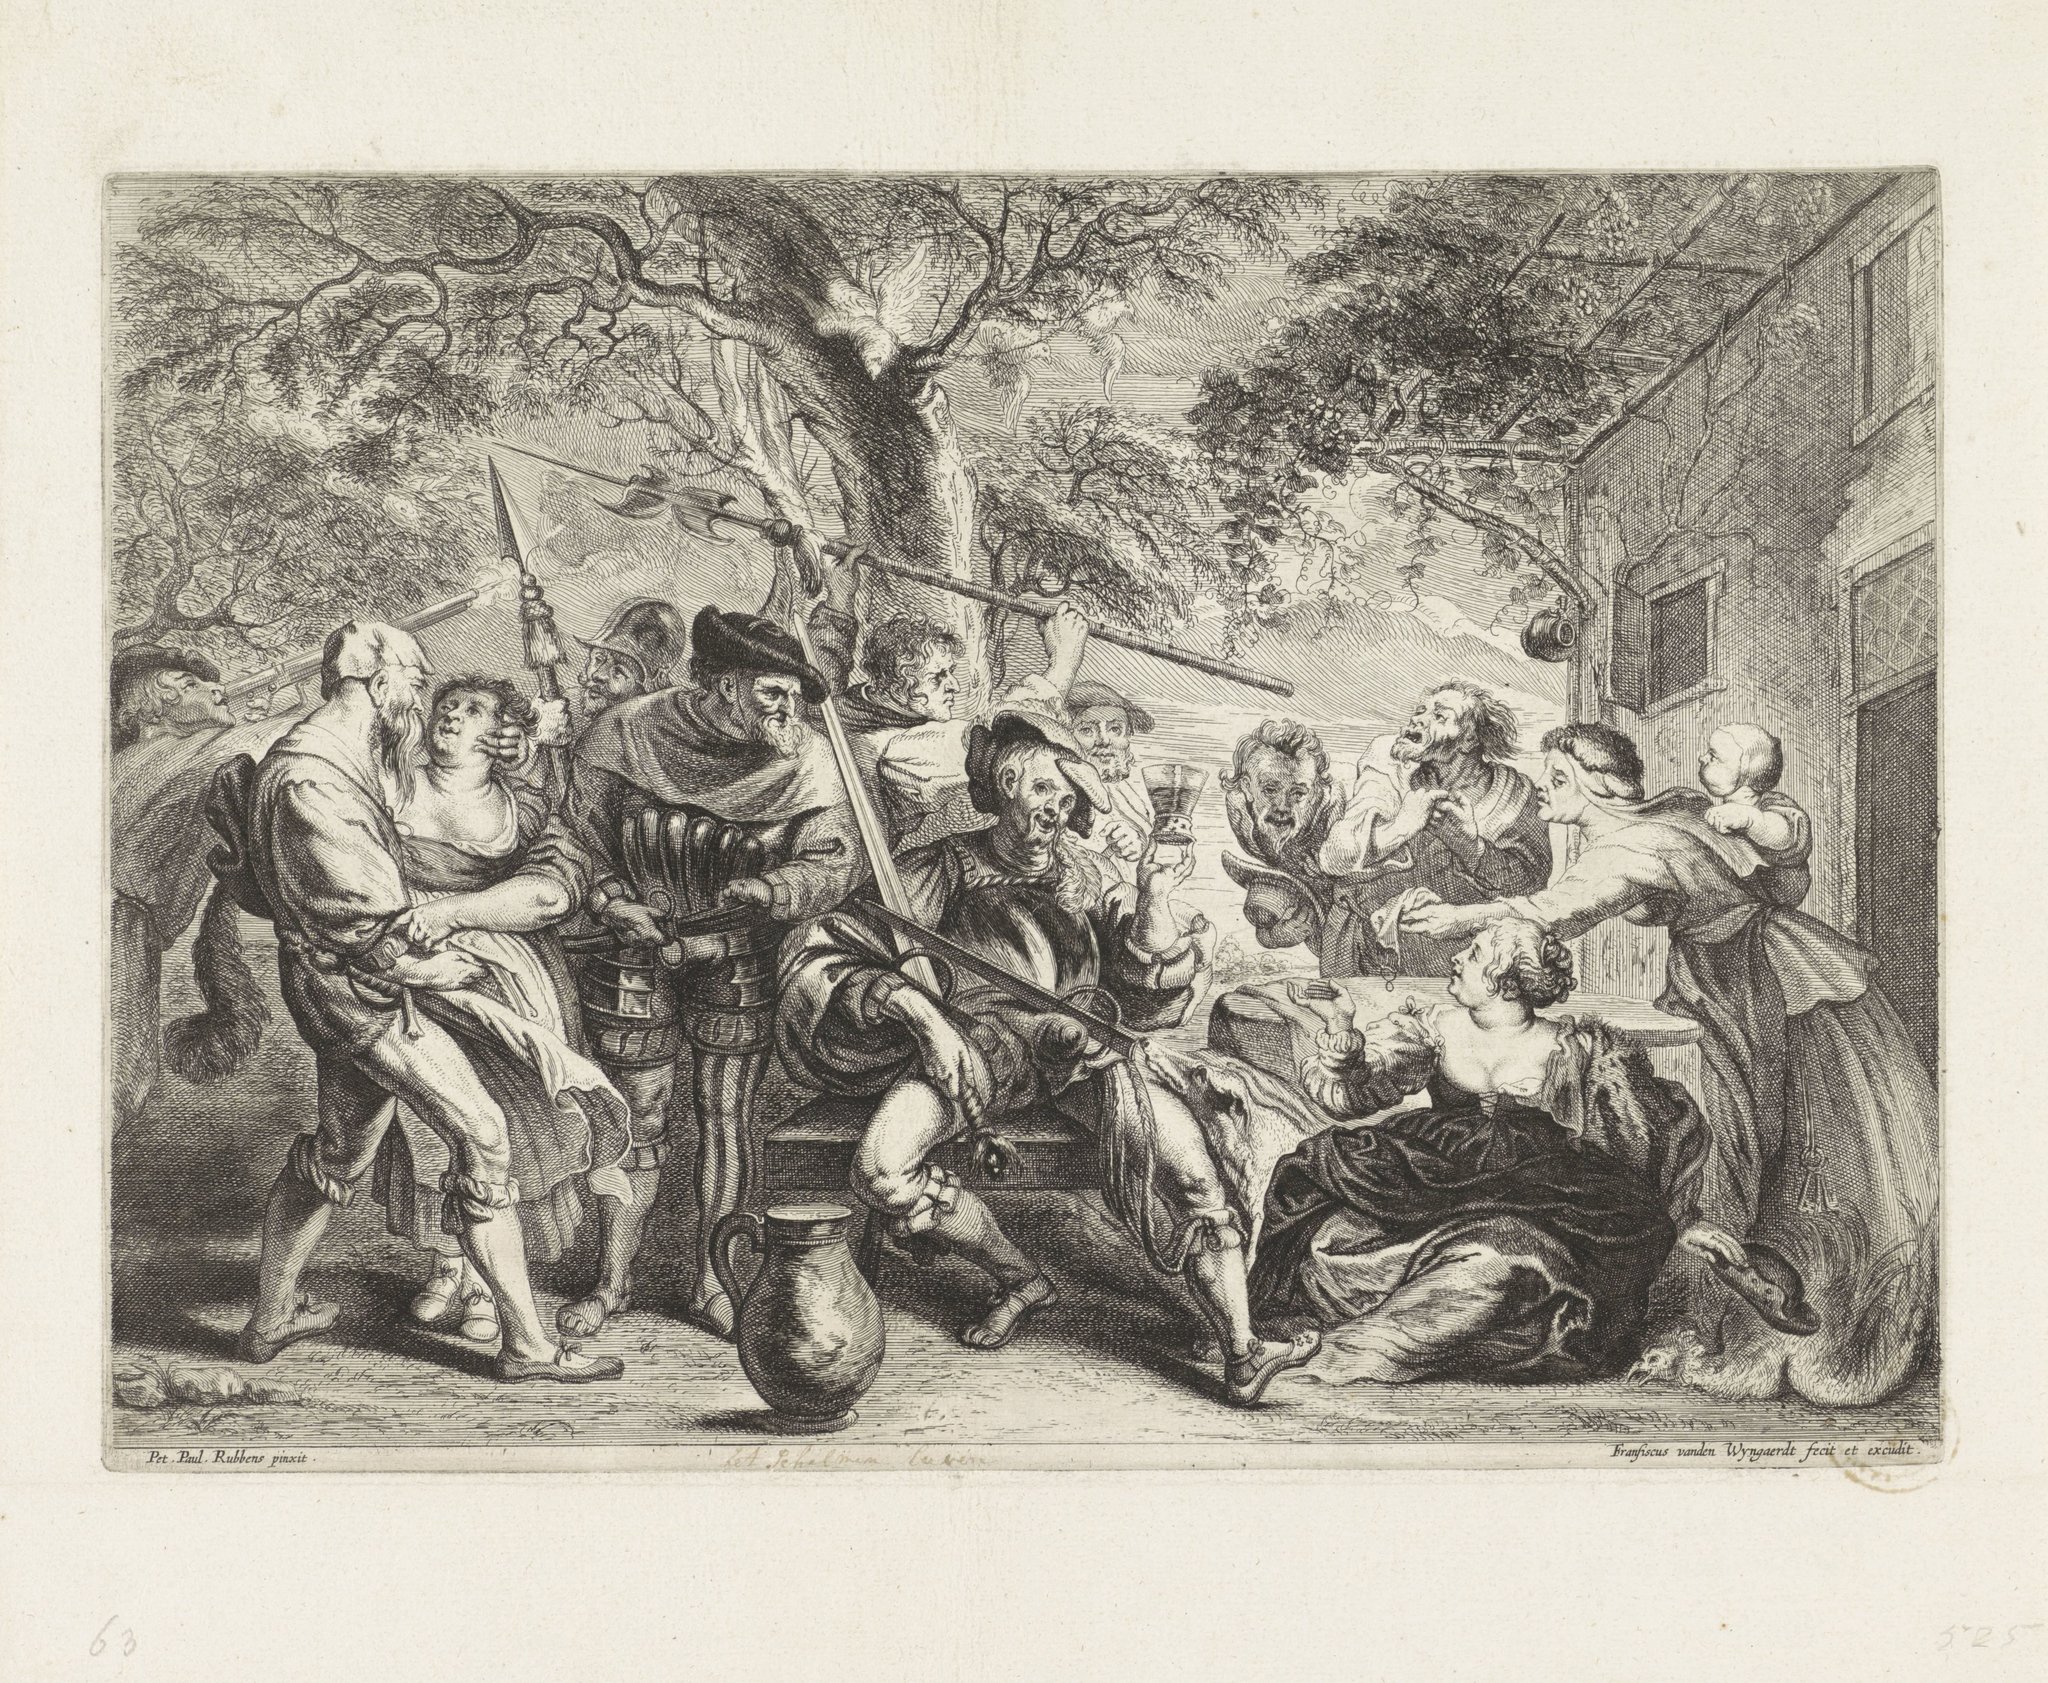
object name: print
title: Feestende boeren en soldaten voor een herberg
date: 1636-1679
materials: paper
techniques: engraving, etching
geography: antwerp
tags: bird hunting, container of glass: bottle, jar, vase, hotel, hostelry, inn, drunken brawl (usually peasants fighting in an inn)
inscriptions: collector's mark: Lugt 240, inscription: ‘het schelmen leven’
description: Een gezelschap soldaten en boeren heeft zich verzameld voor een herberg. In het midden heft een man zijn glas. Aan zijn voeten staat een grote kan. Links schiet een soldaat op de vogels die in de boom zitten.